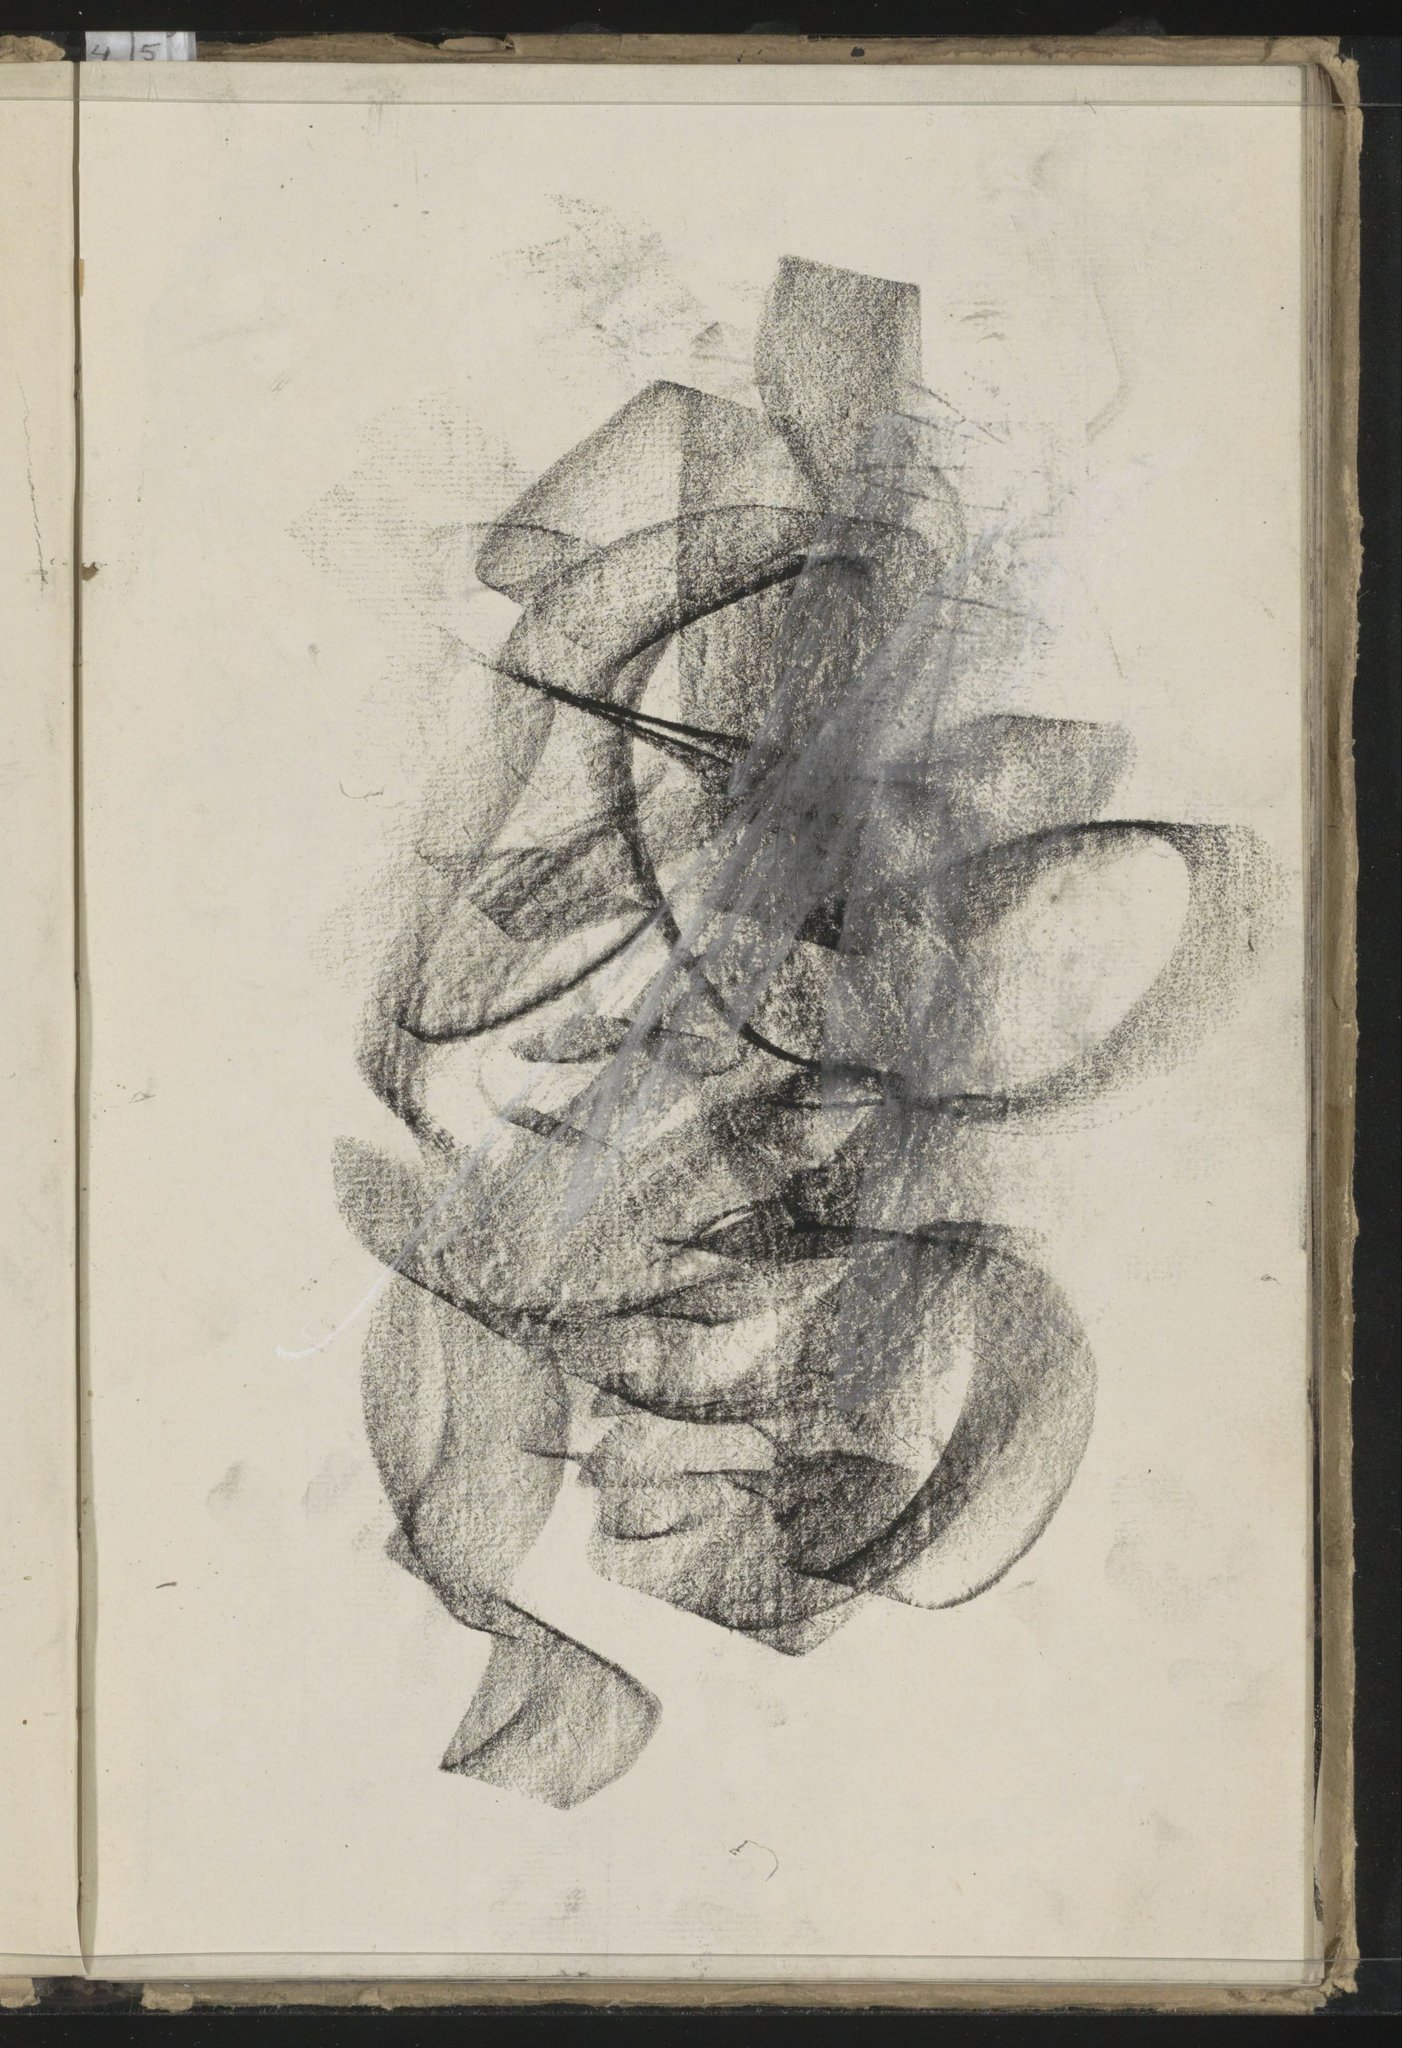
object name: sketchbook leaf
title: Studie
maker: carel adolph lion cachet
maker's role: draughtsman, print maker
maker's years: 1864-1945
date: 1890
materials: chalk, paper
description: Blad 4 recto uit een schetsboek met 38 bladen.